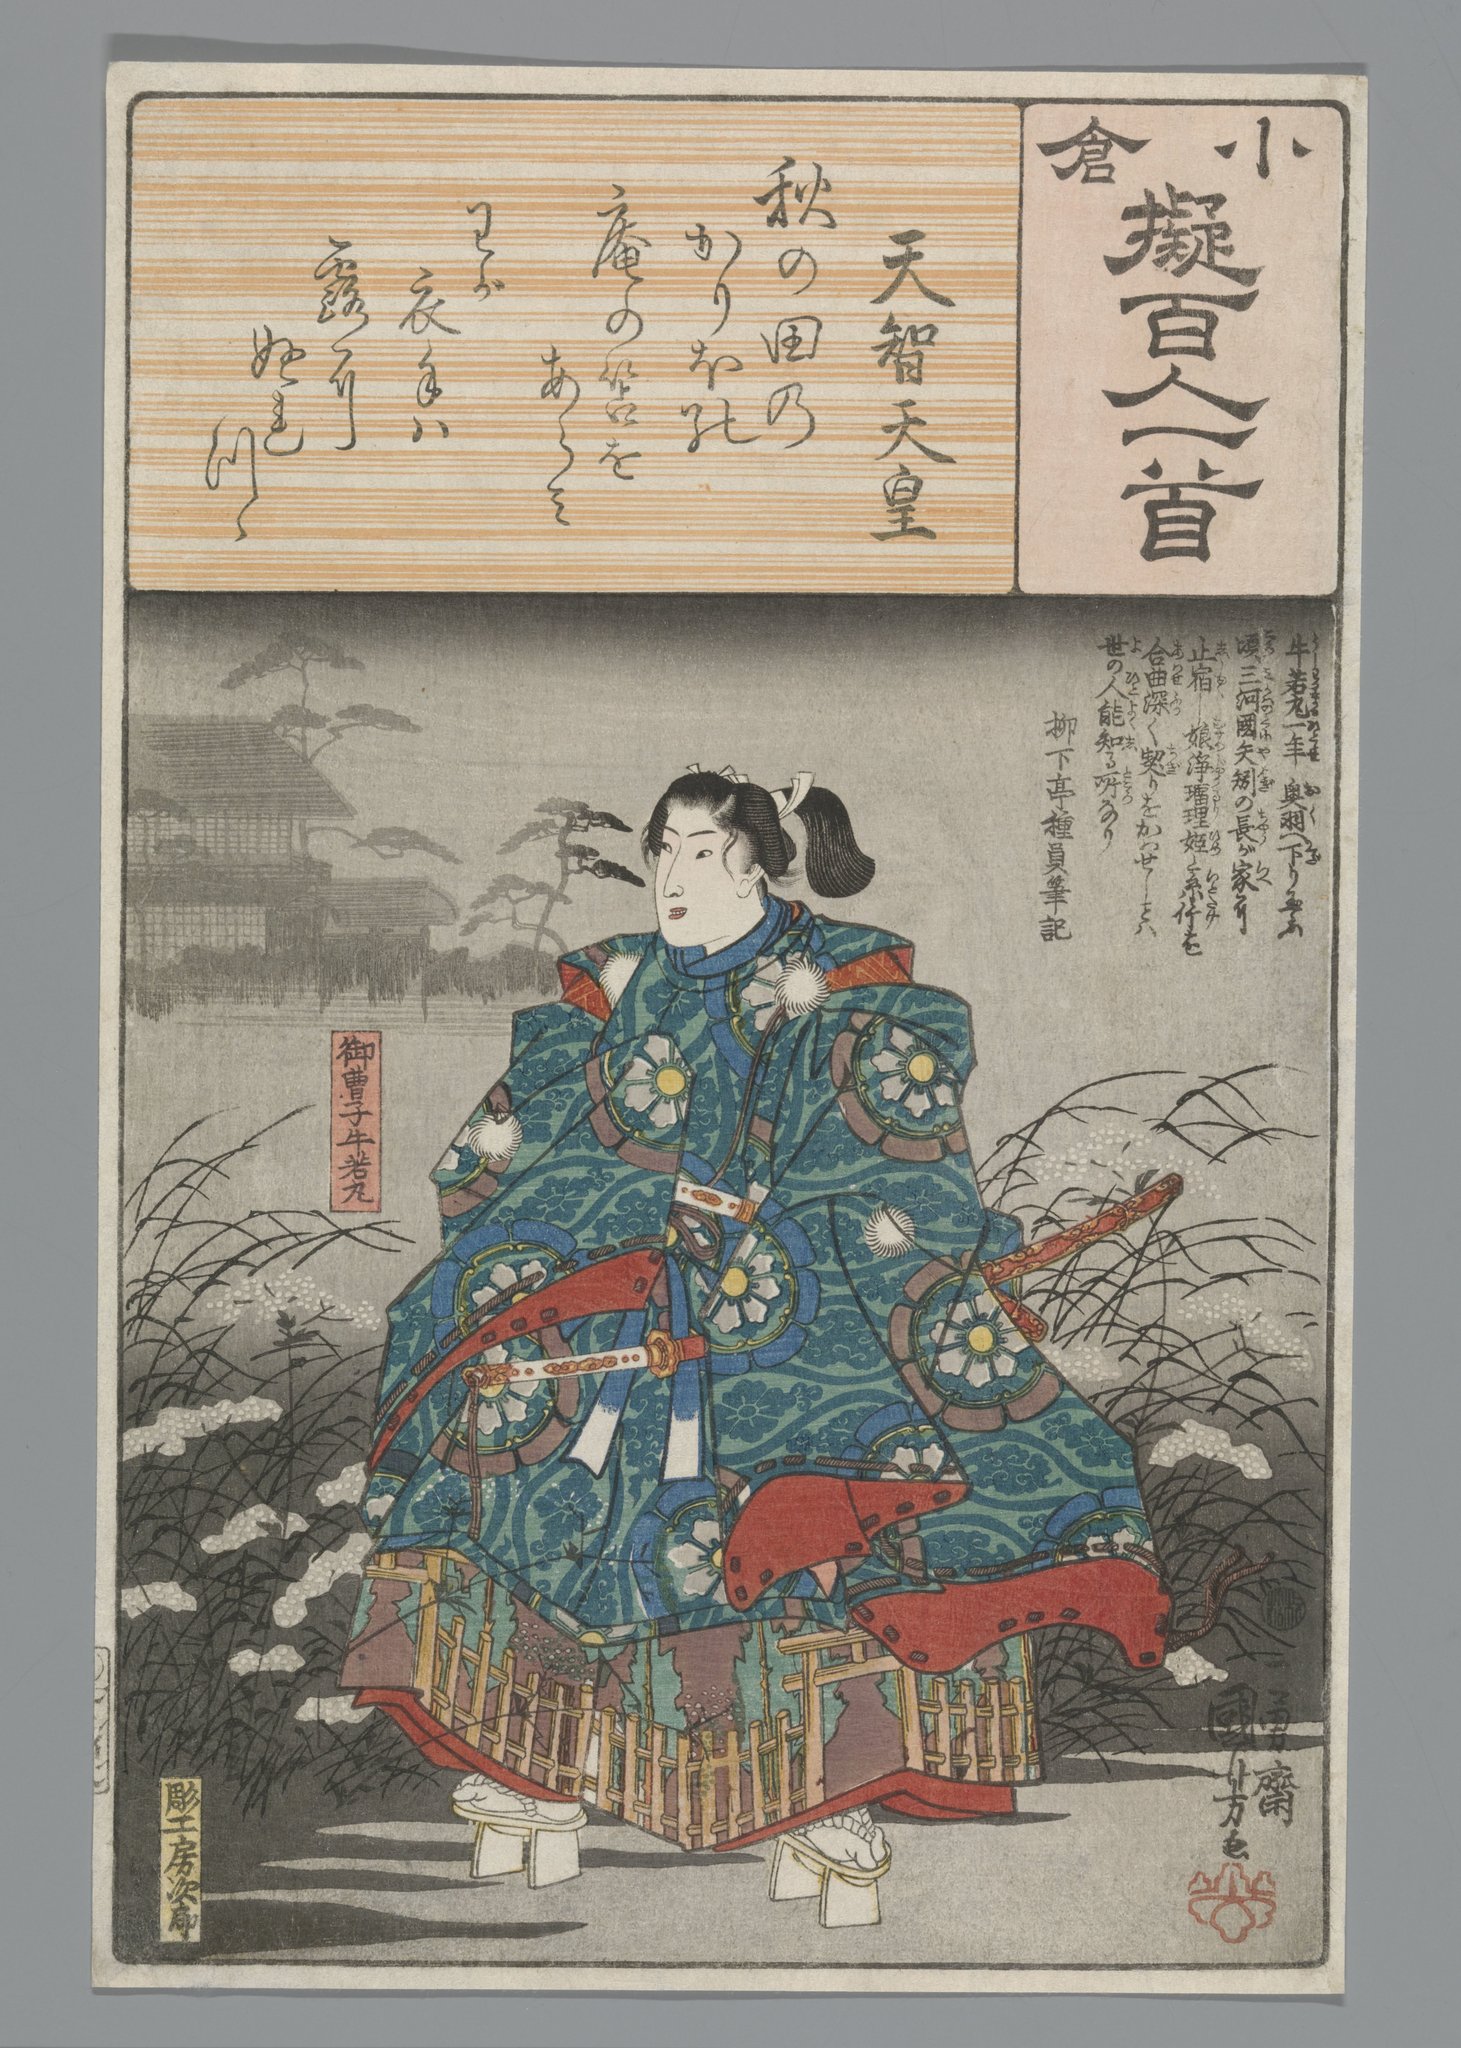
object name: print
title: Emperor Tenji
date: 1845-1846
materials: paper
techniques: woodcut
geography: japan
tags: garden, mist, fog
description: Ushiwakamaru in een jachtkostuum van groen brocade, staat in de mist in de tuin van het huis van prinses Jôruri. Scene uit een kabukitoneelstuk. Gedicht door de zevende eeuwse keizer Tenji.